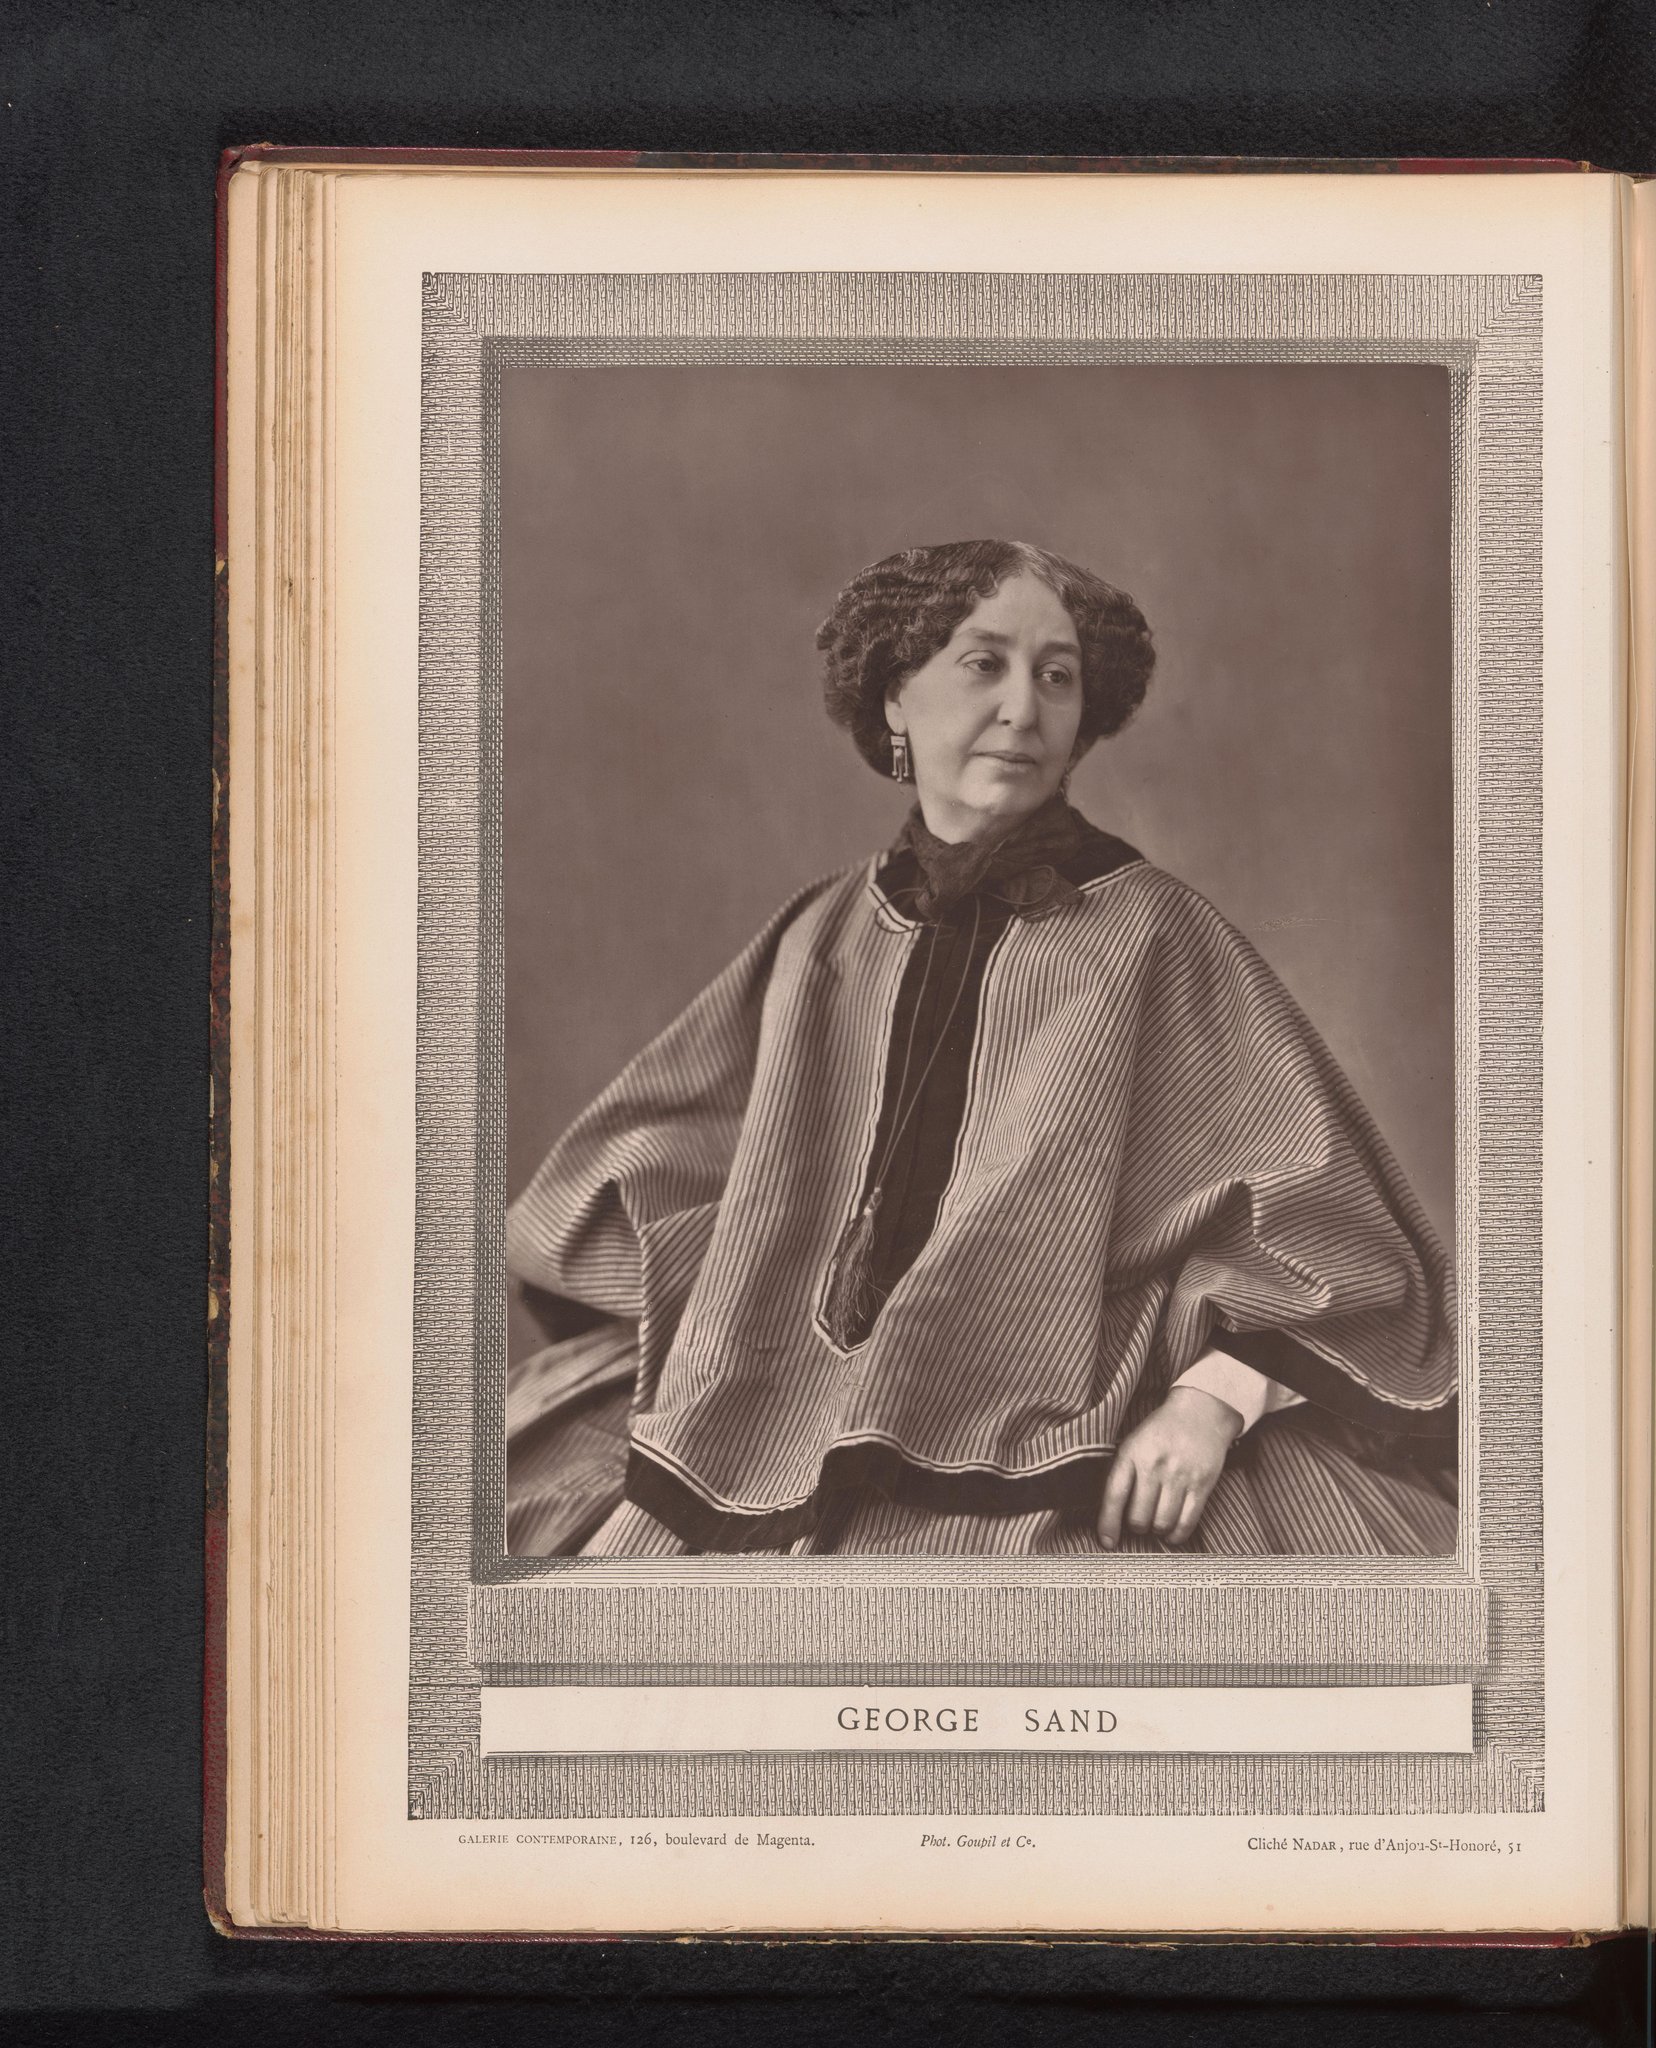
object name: page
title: George Sand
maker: félix nadar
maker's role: ballonvaarder, fotograaf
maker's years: 1820-1910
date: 1872-1877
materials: paper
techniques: woodburytype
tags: george sand, adult woman, historical persons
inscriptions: inscription: ‘Galerie Contemporaine, 126, boulevard de Magenta.’